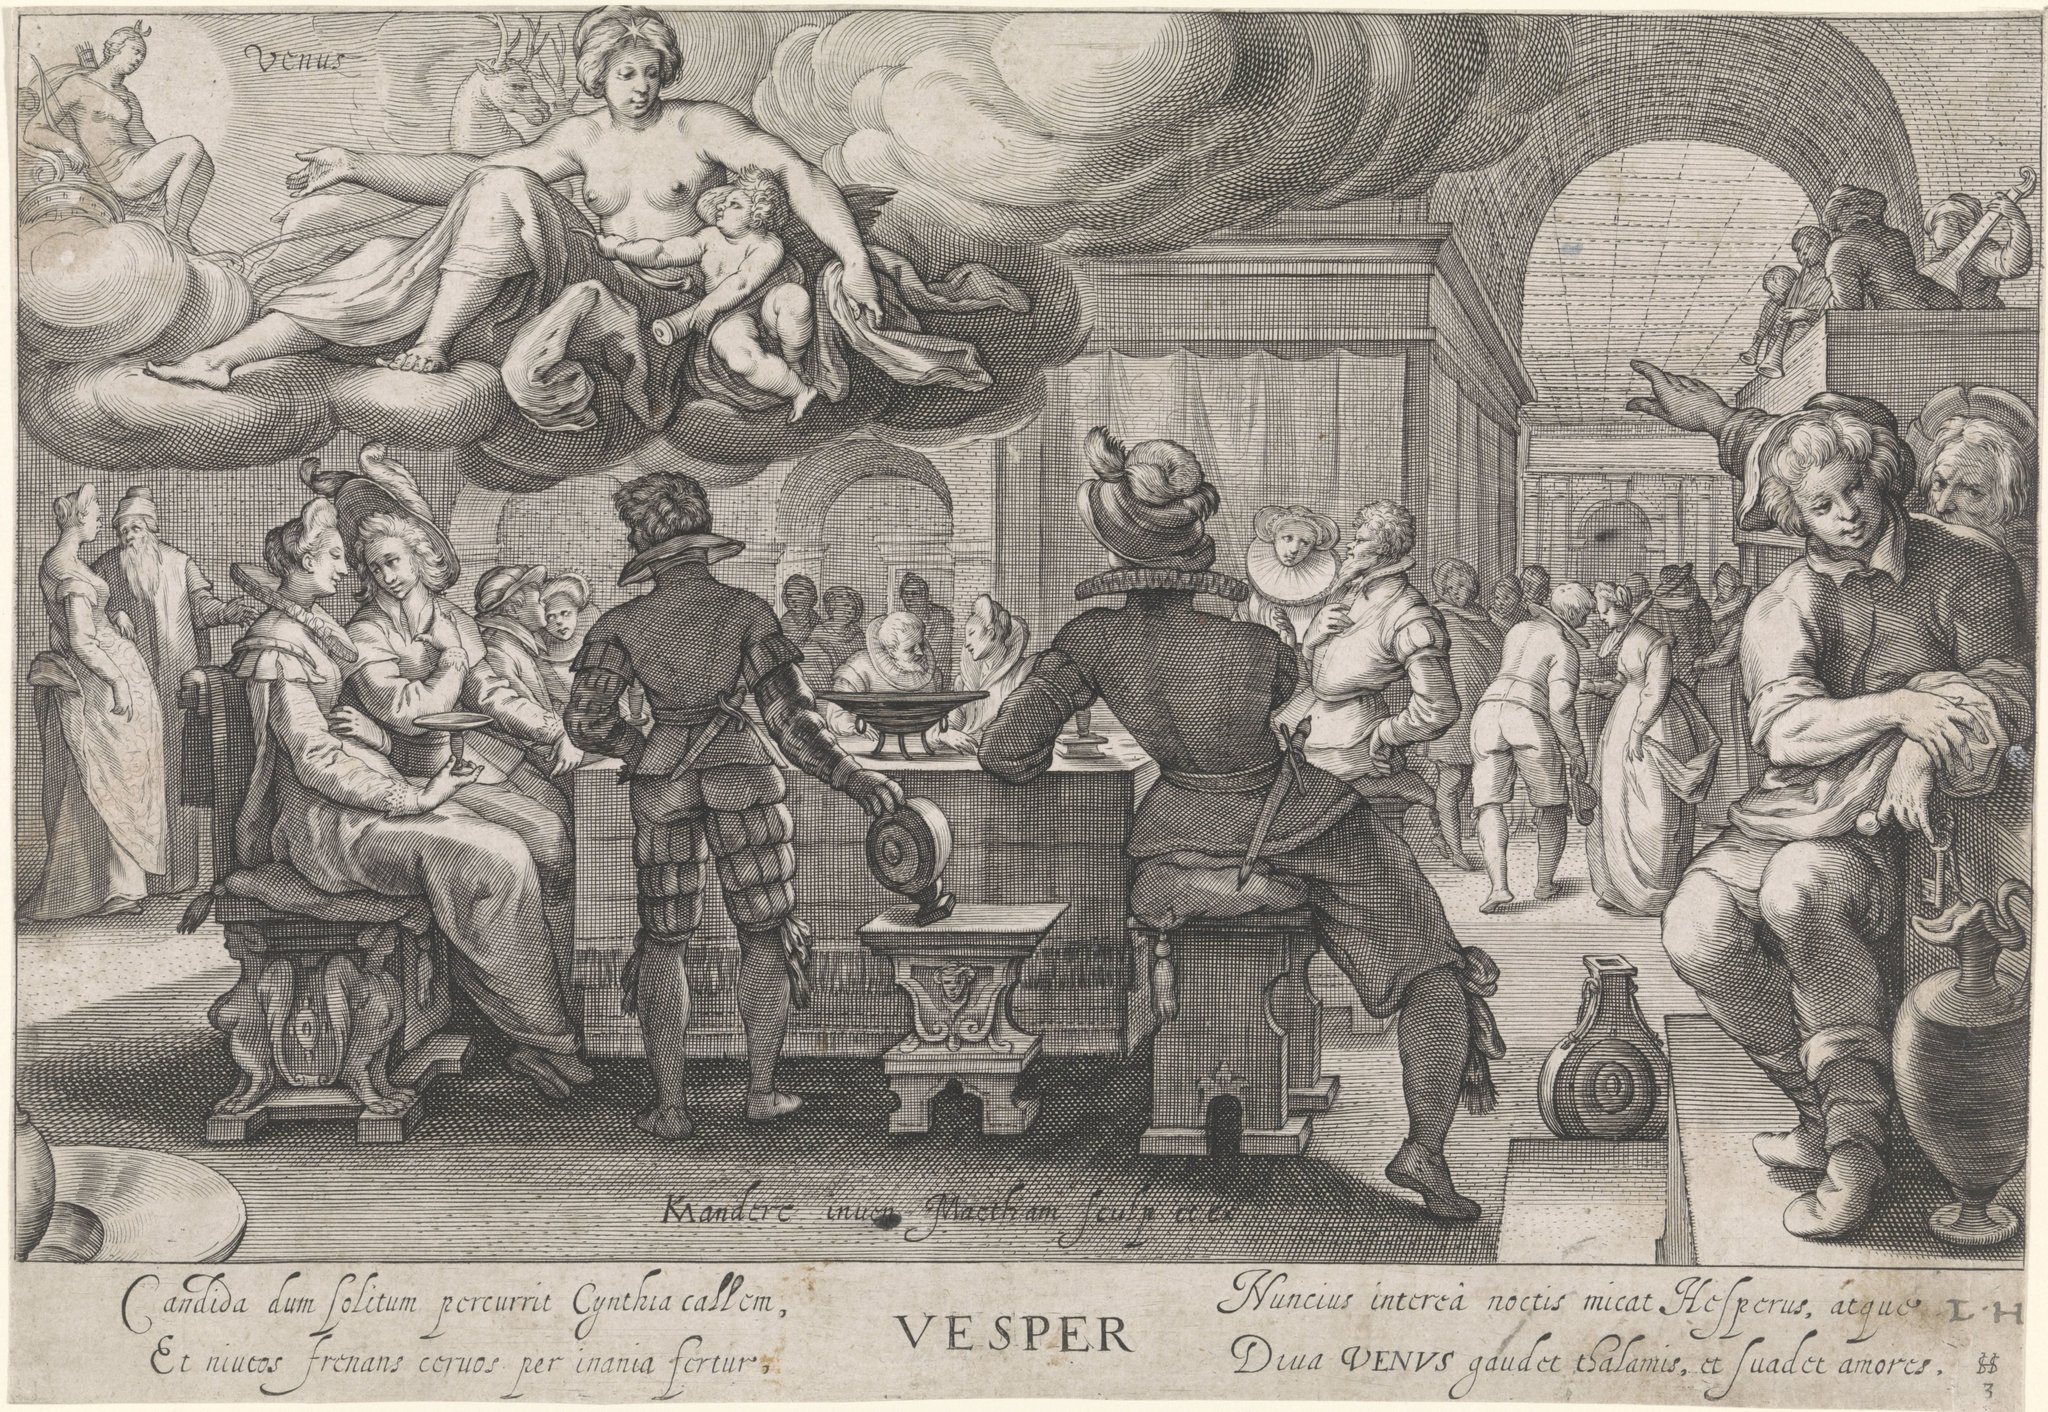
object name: print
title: Vesper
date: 1601-1605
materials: paper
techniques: engraving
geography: haarlem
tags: evening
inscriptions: collector's mark: Lugt 2228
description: Avond. Allegorische voorstelling van de avond, met in de wolken Venus met Amor en Diana als de maangodin Luna. Daaronder vele heren en dames met elkaar in gesprek in een interieur.